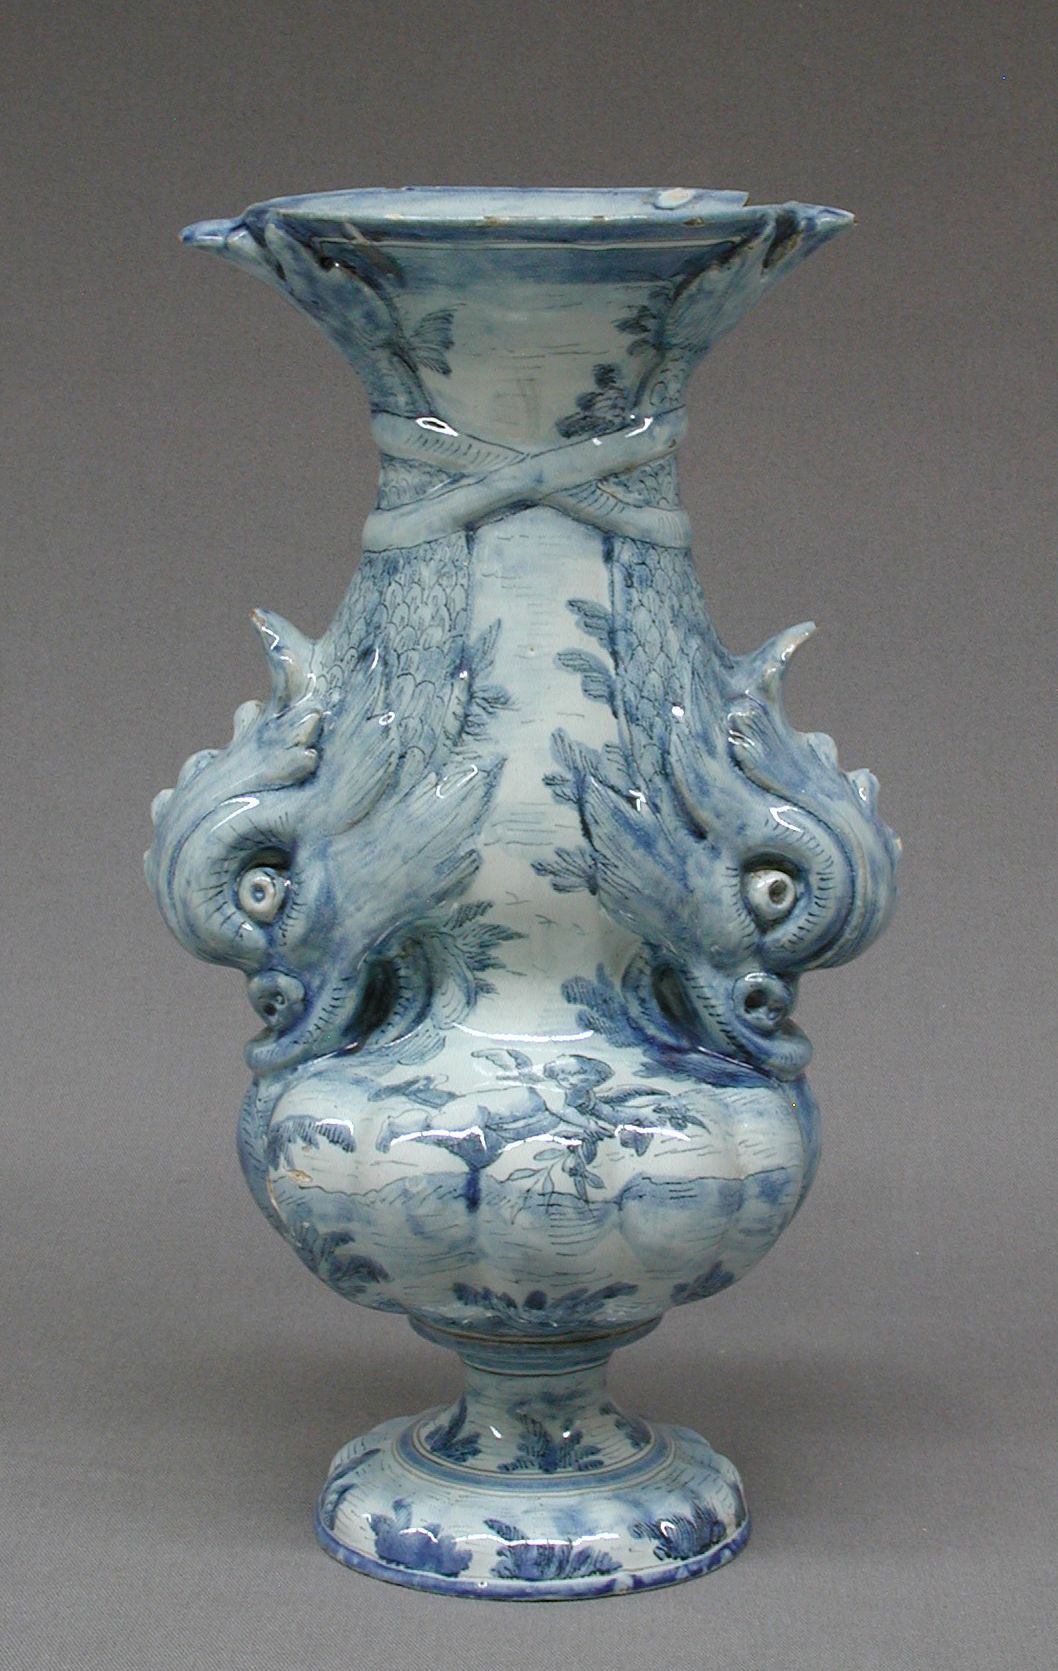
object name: vase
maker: ulisse cantagalli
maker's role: factory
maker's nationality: italian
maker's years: 1839-1901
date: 1867-1900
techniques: maiolica, glazing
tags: dolphins